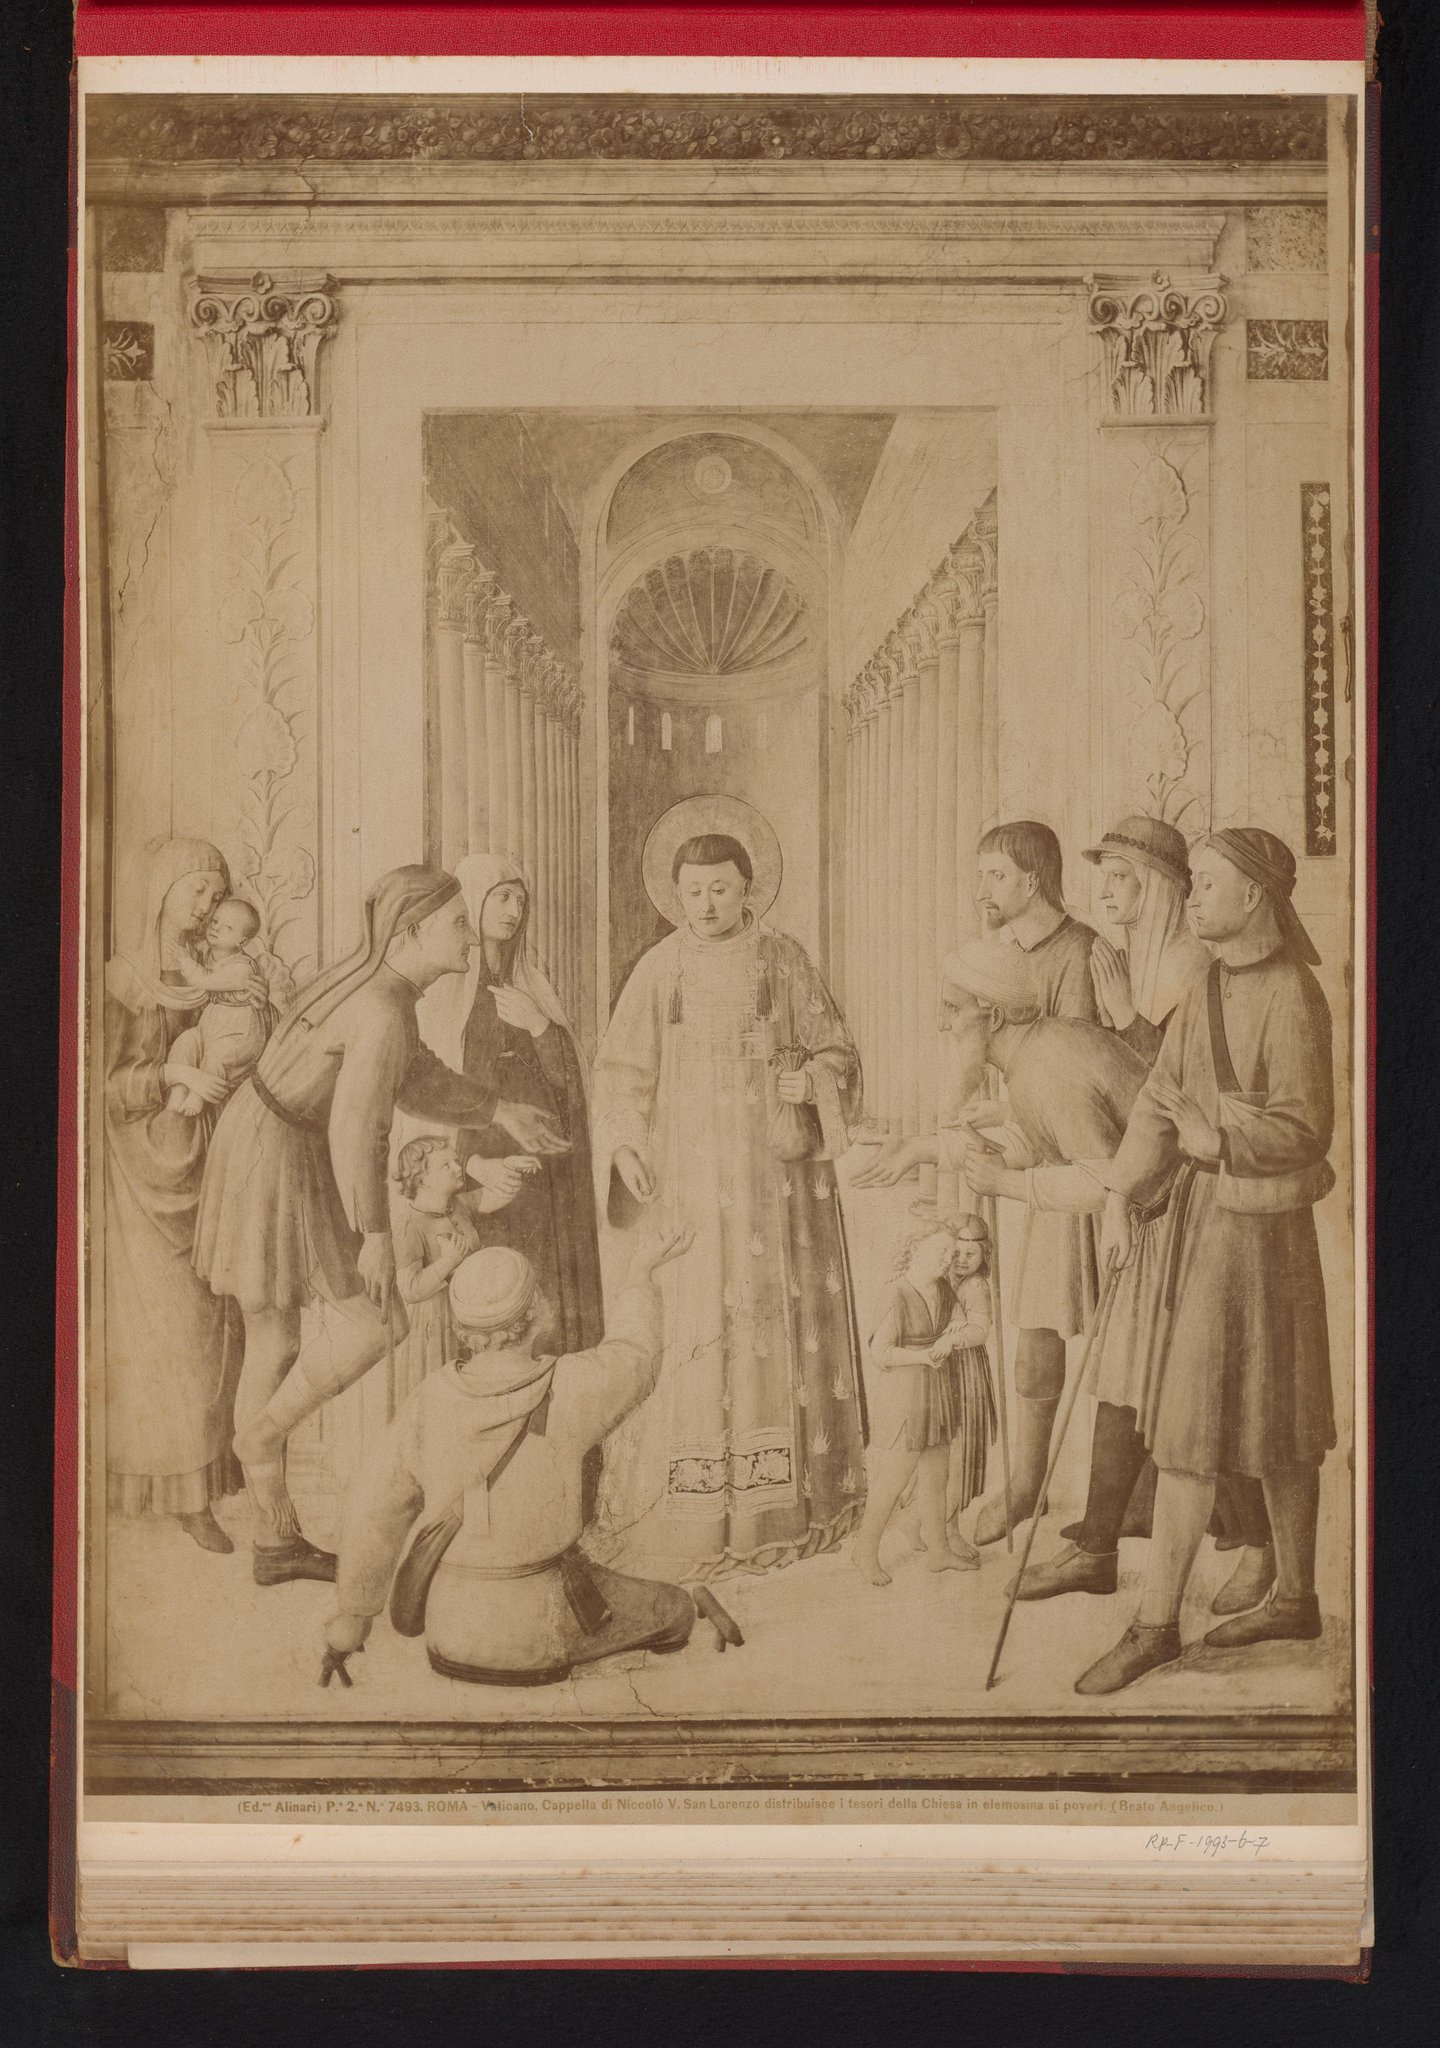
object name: album leaf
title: Fotoreproductie van fresco De heilige Laurentius deelt aalmoezen uit, door Fra Angelico, Kapel van Nicolaas V, Vaticaan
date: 1860-1900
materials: paper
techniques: albumen print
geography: chapel of nicholas v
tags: the martyr and deacon laurence of rome; possible attributes: book, censer, cross, dalmatic, gridiron, palm, purse (or cup with golden coins), picture, painting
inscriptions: inscription: ‘(Ed.ne Alinari) P.e 2.a N.o 7490. ROMA - Vaticano, Capello di Niccolò V. San Lorenzo distribuisce i tresori della Chiesa in elemosina ai poveri (Beato Angelico.)’